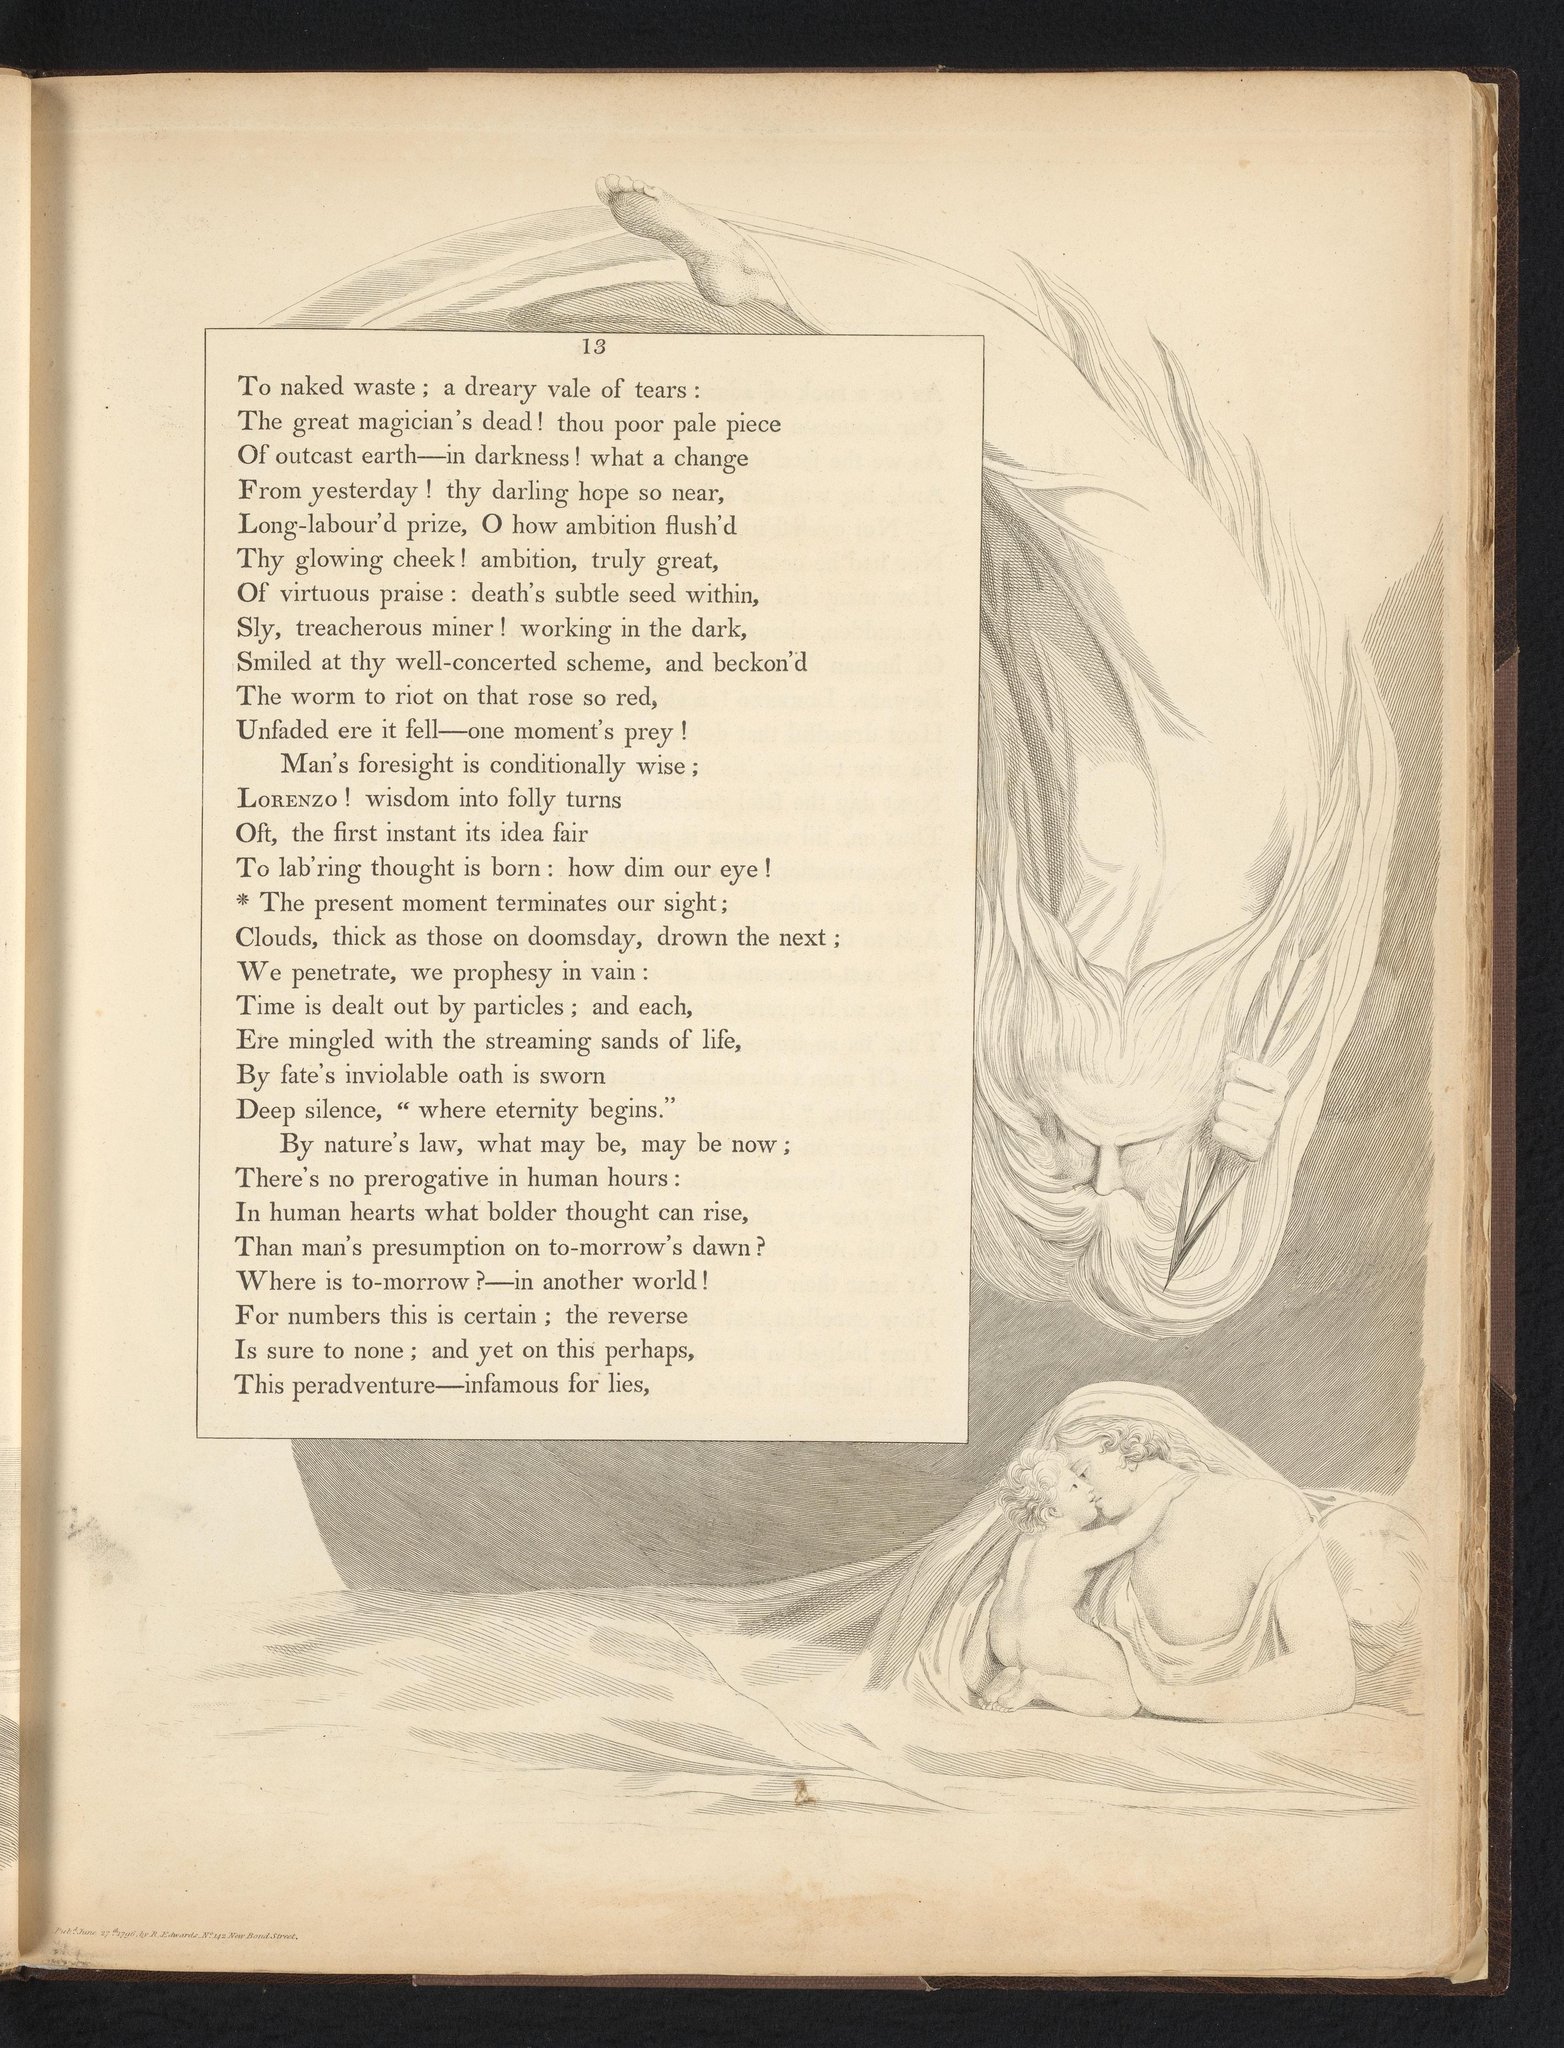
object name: print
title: Man met baard en pijl zwevend boven een vrouw met kind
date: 1796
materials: paper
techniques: engraving, letterpress printing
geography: london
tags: adult man, archer's weapons: arrow, mother and child(ren), woman and child(ren) (family group), beard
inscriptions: : ‘To naked waste ; a dreary vale of tears (...)’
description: Prent maakt deel uit van een boek, bladzijde 13. Tekst in het Engels op recto en verso.